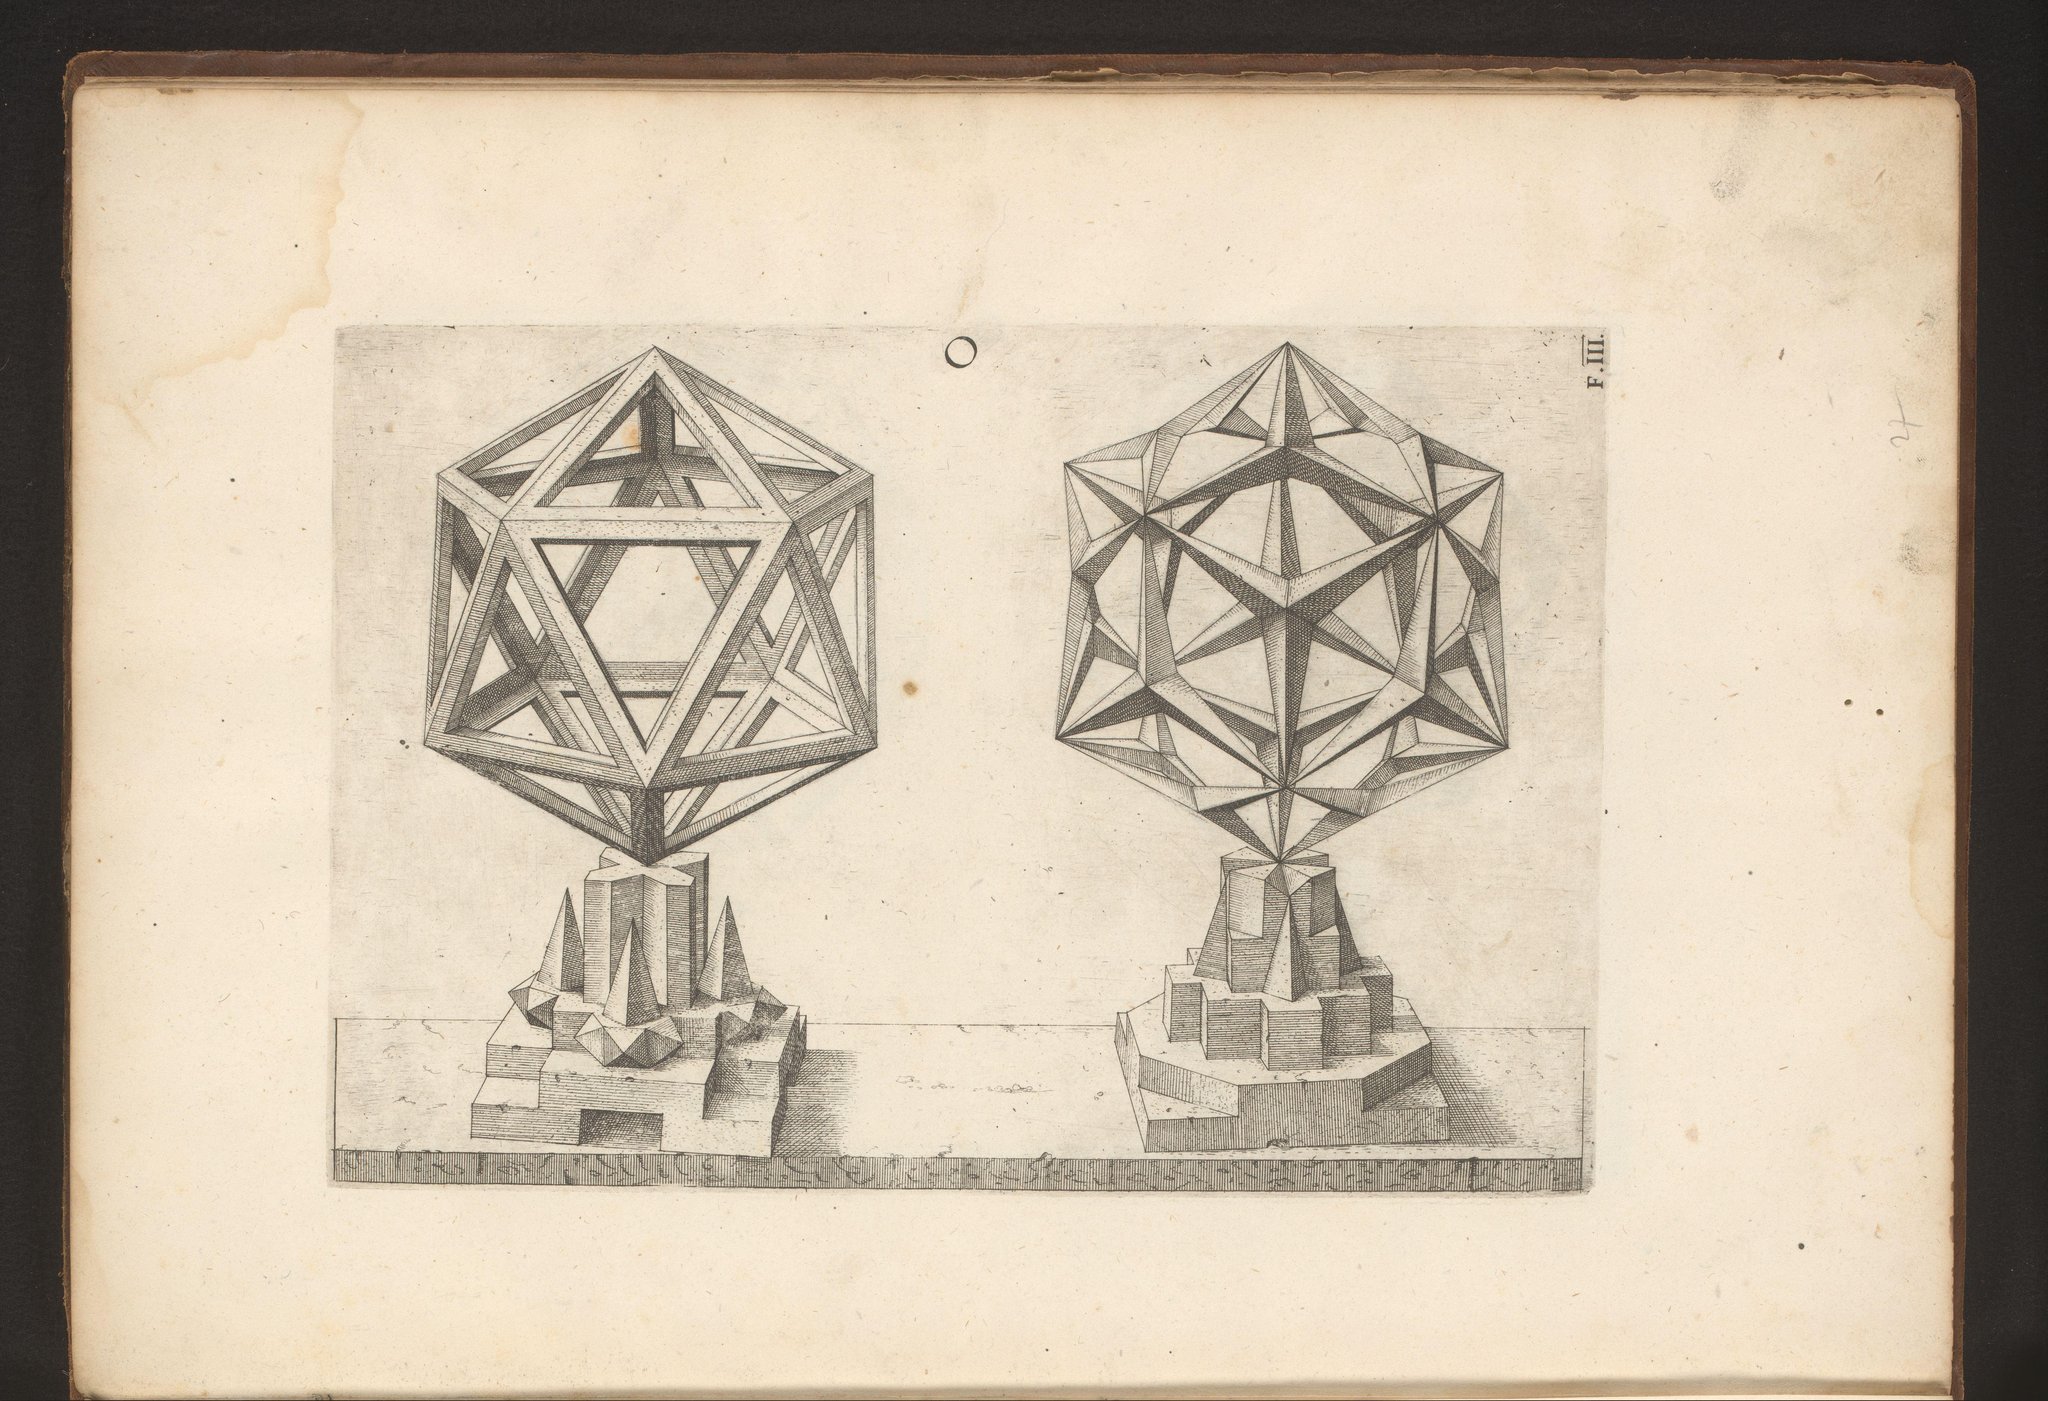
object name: book illustration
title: Twee veelvlakken met een icosaëder en een rombische triacontaëder als uitgangspunt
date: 1568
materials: paper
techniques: etching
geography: nuremberg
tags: other polyhedrons, icosahedron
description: De geometrische figuren (polyhedra) worden van links naar rechts complexer. Gelabeld als 'O' en genummerd: F.III. Deze prent maakt deel uit van een boek.